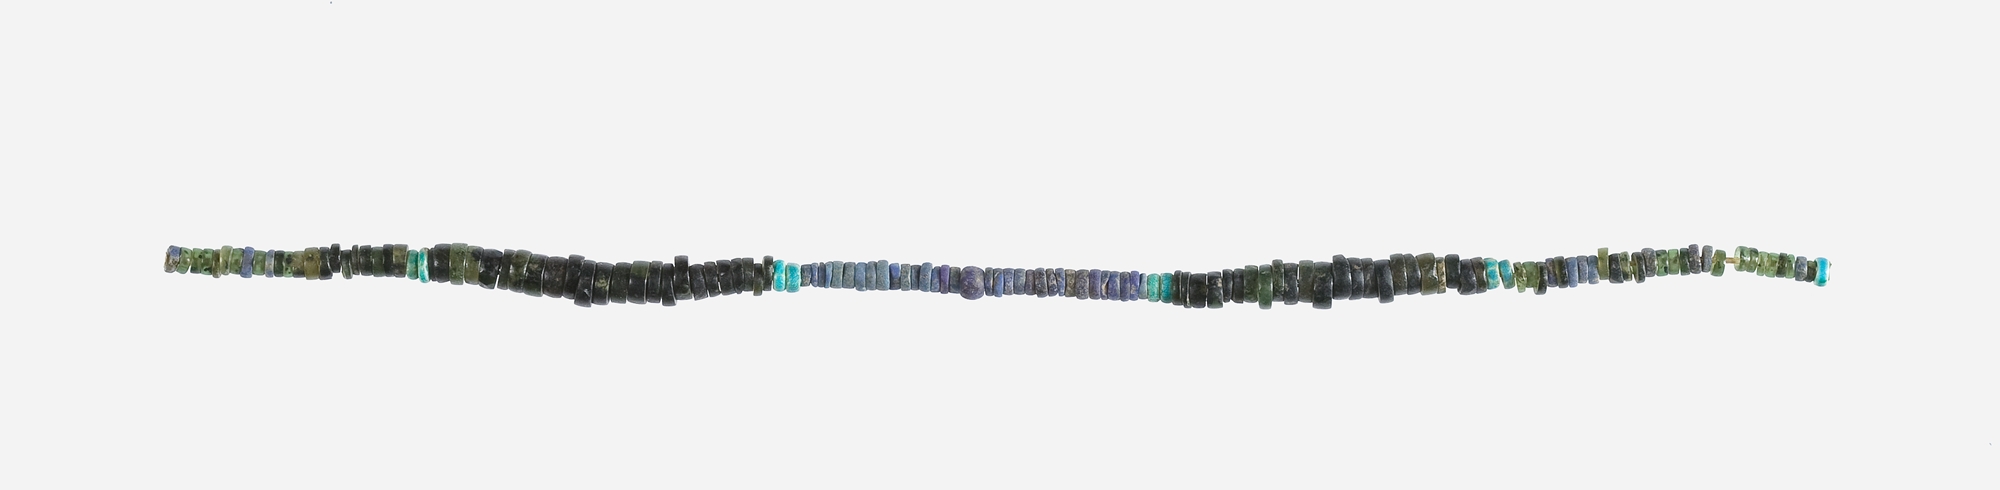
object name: diadem, bead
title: Semi-diadem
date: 3500-3300 BCE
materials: lapis lazuli, stone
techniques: glazing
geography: egypt